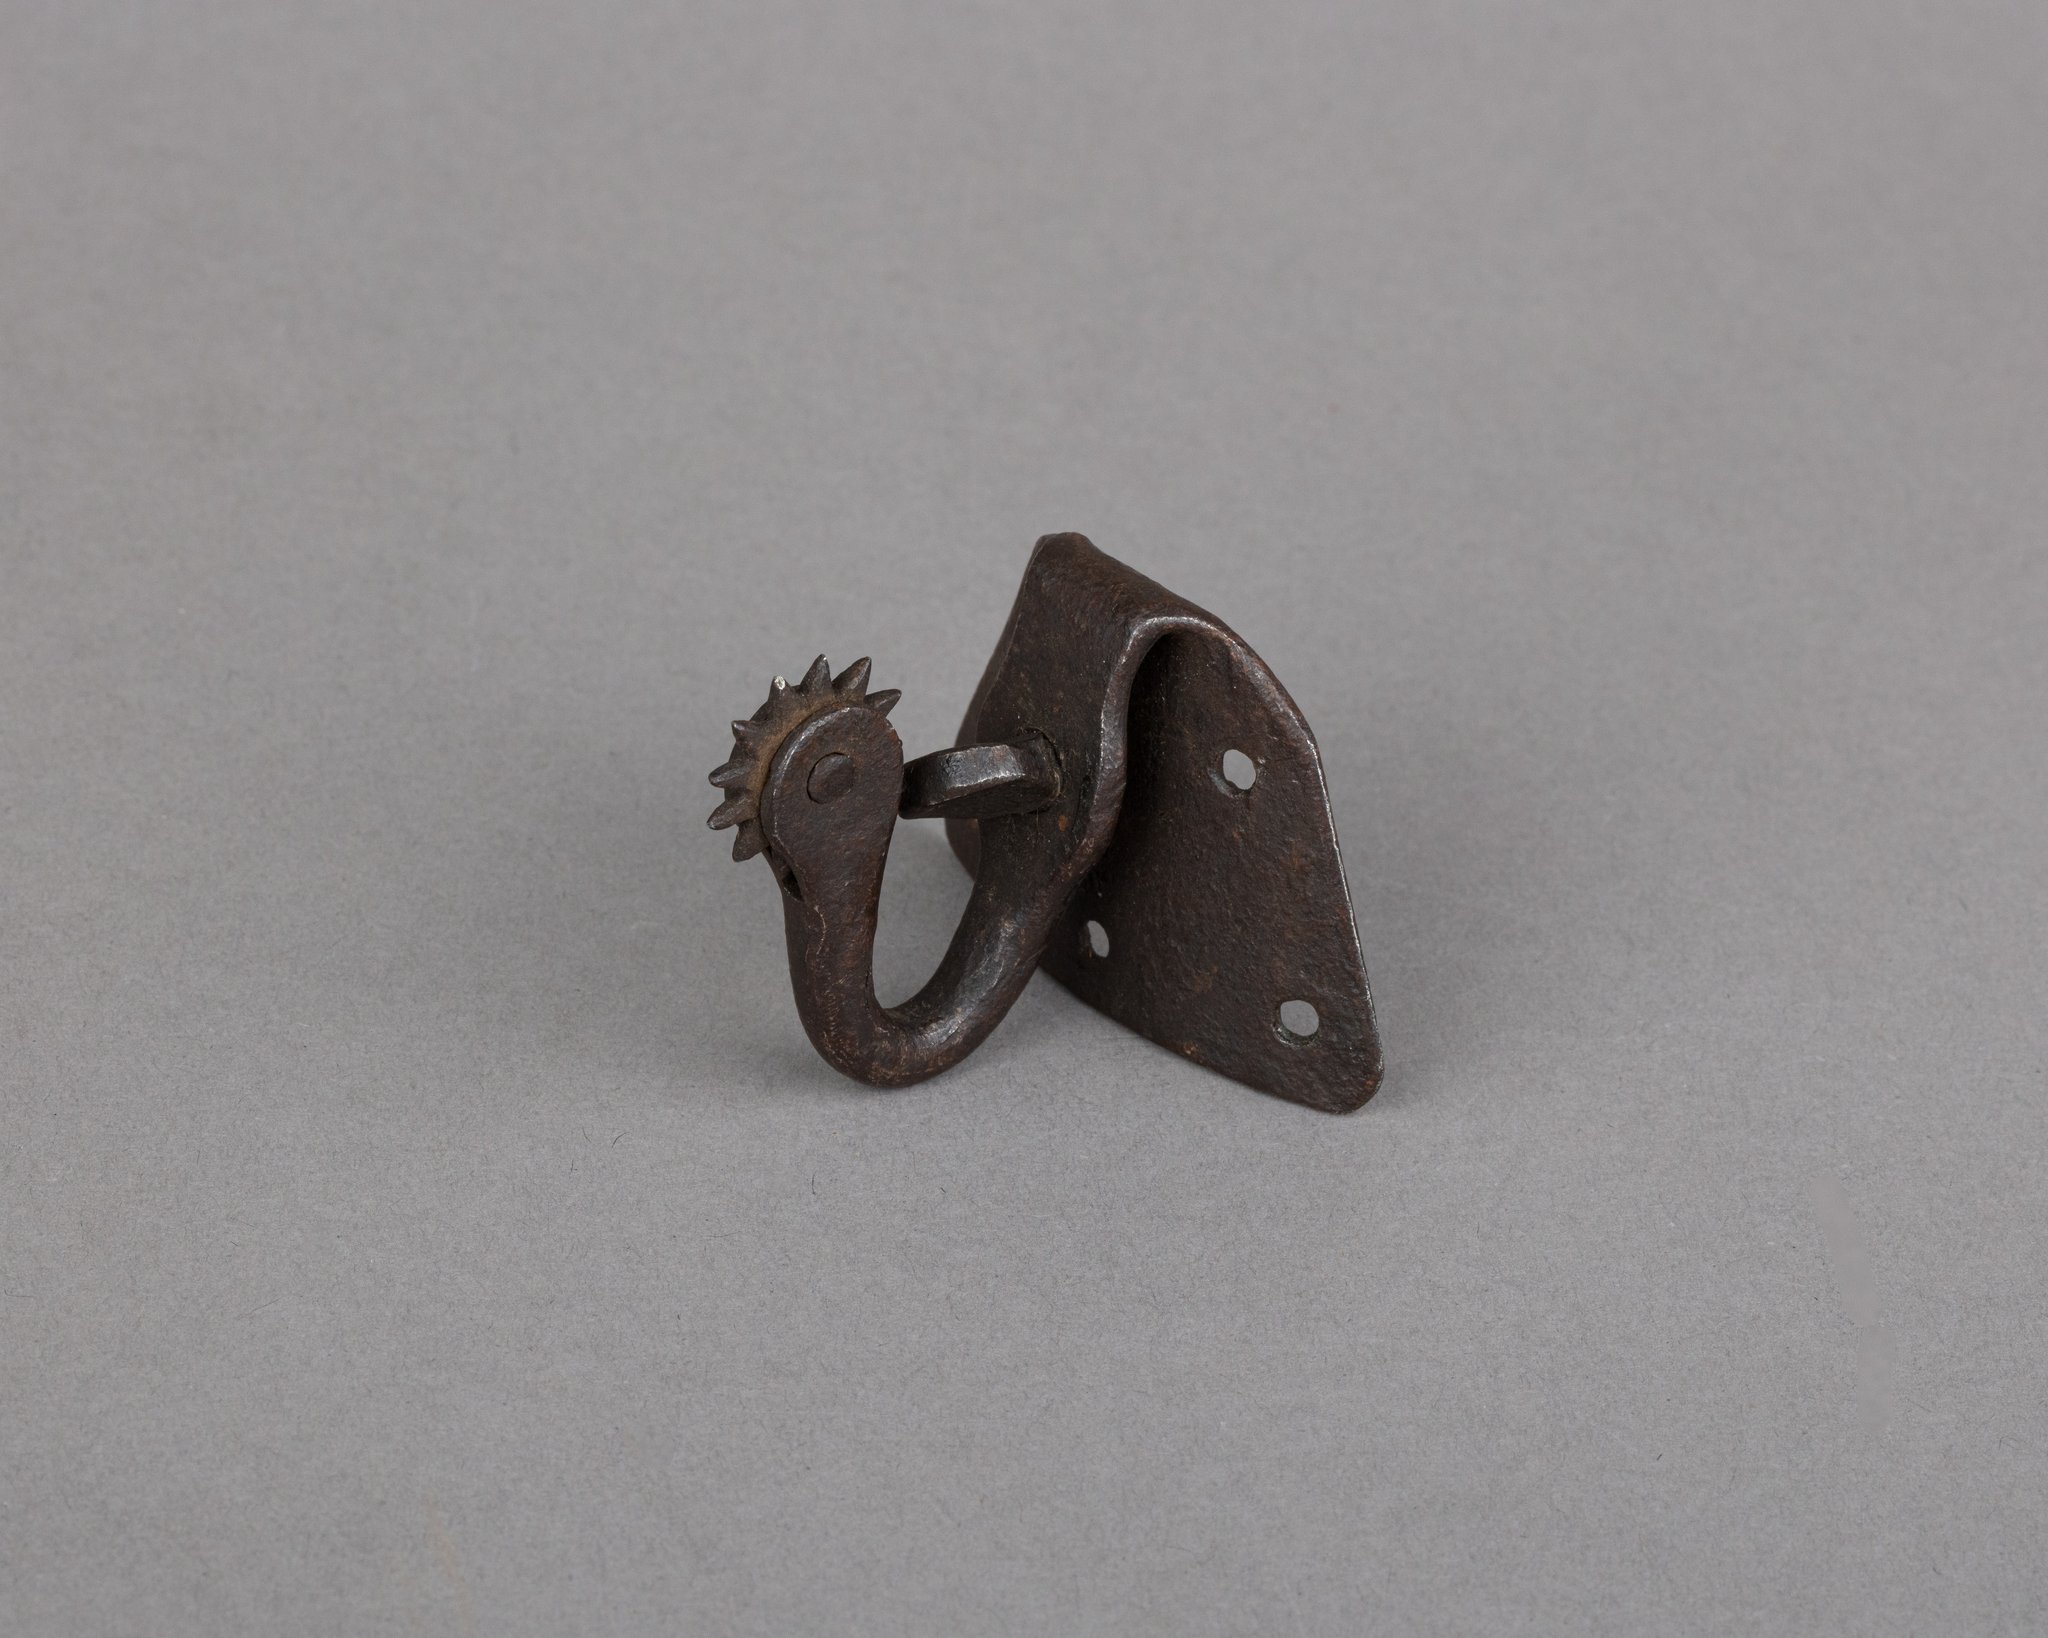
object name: spur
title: Rowel Spur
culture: german or italian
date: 1701-1800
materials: metal alloy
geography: germany